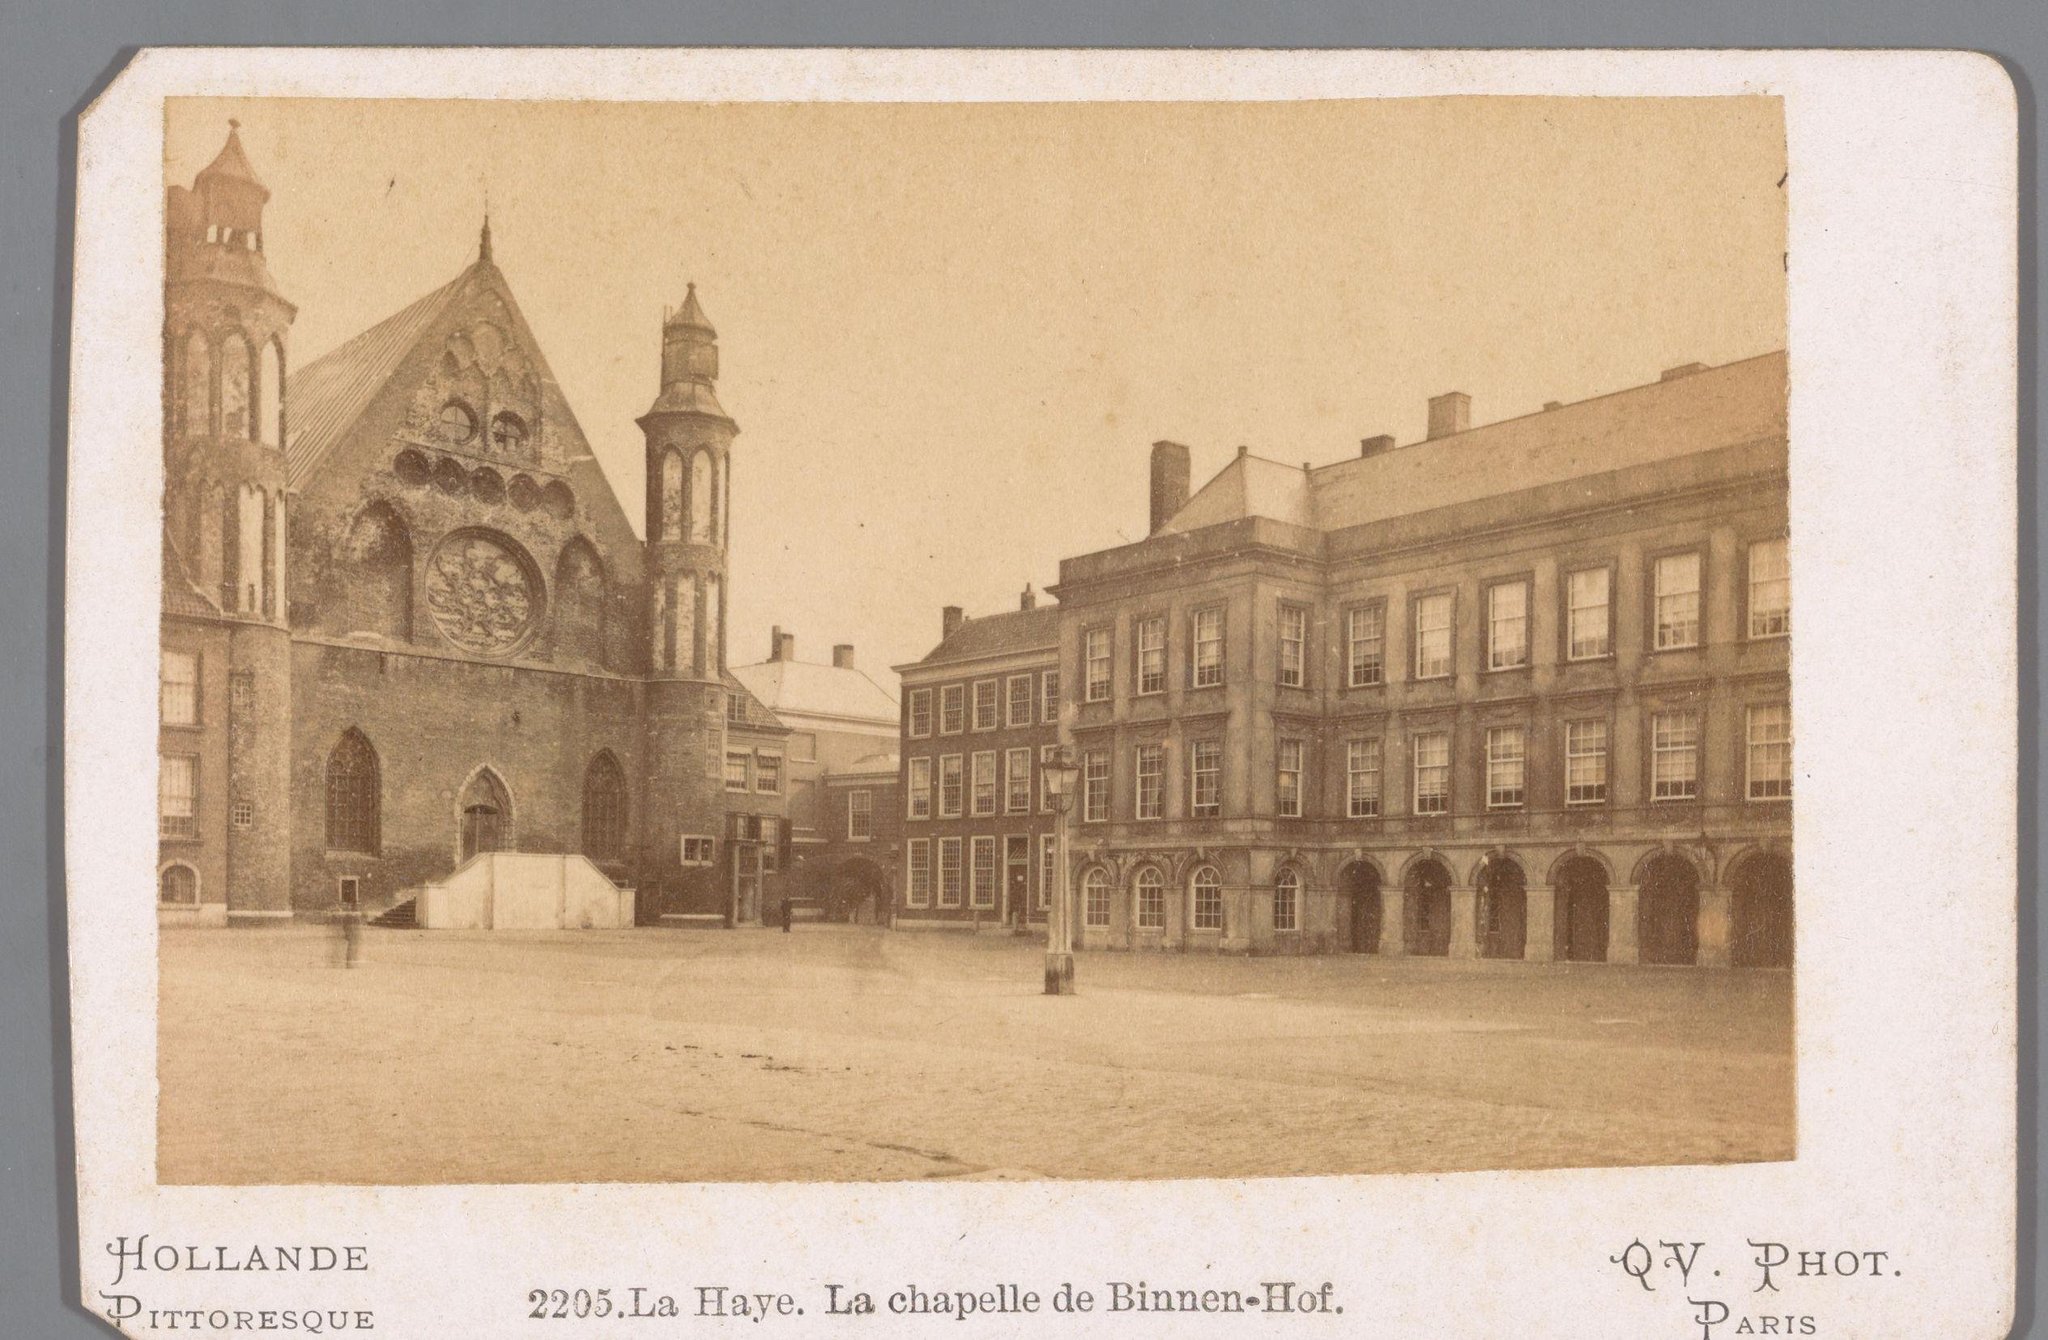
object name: photograph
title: Gezicht op de Ridderzaal en het Binnenhof in Den Haag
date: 1850-1877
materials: cardboard, photographic support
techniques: albumen print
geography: the hague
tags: square, place, circus, etc.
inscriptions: annotation: ‘COLLECTIONS STÉRÉOSCOPIQUES/ COMPLÈTES/ DE FRANCE, BELGIQUE,/ HOLLANDE, LONDRES,/ BORDS DU RHIN, ETC./ QUÉVAL, EDITEUR/ 22bis Rue Chaptal/ PARIS.’, number: ‘20-’, inscription: ‘HOLLANDE/ PITTORESQUE/ 2205. La Haye. La chapelle de Binnen-Hof./ Q.V. / PARIS’